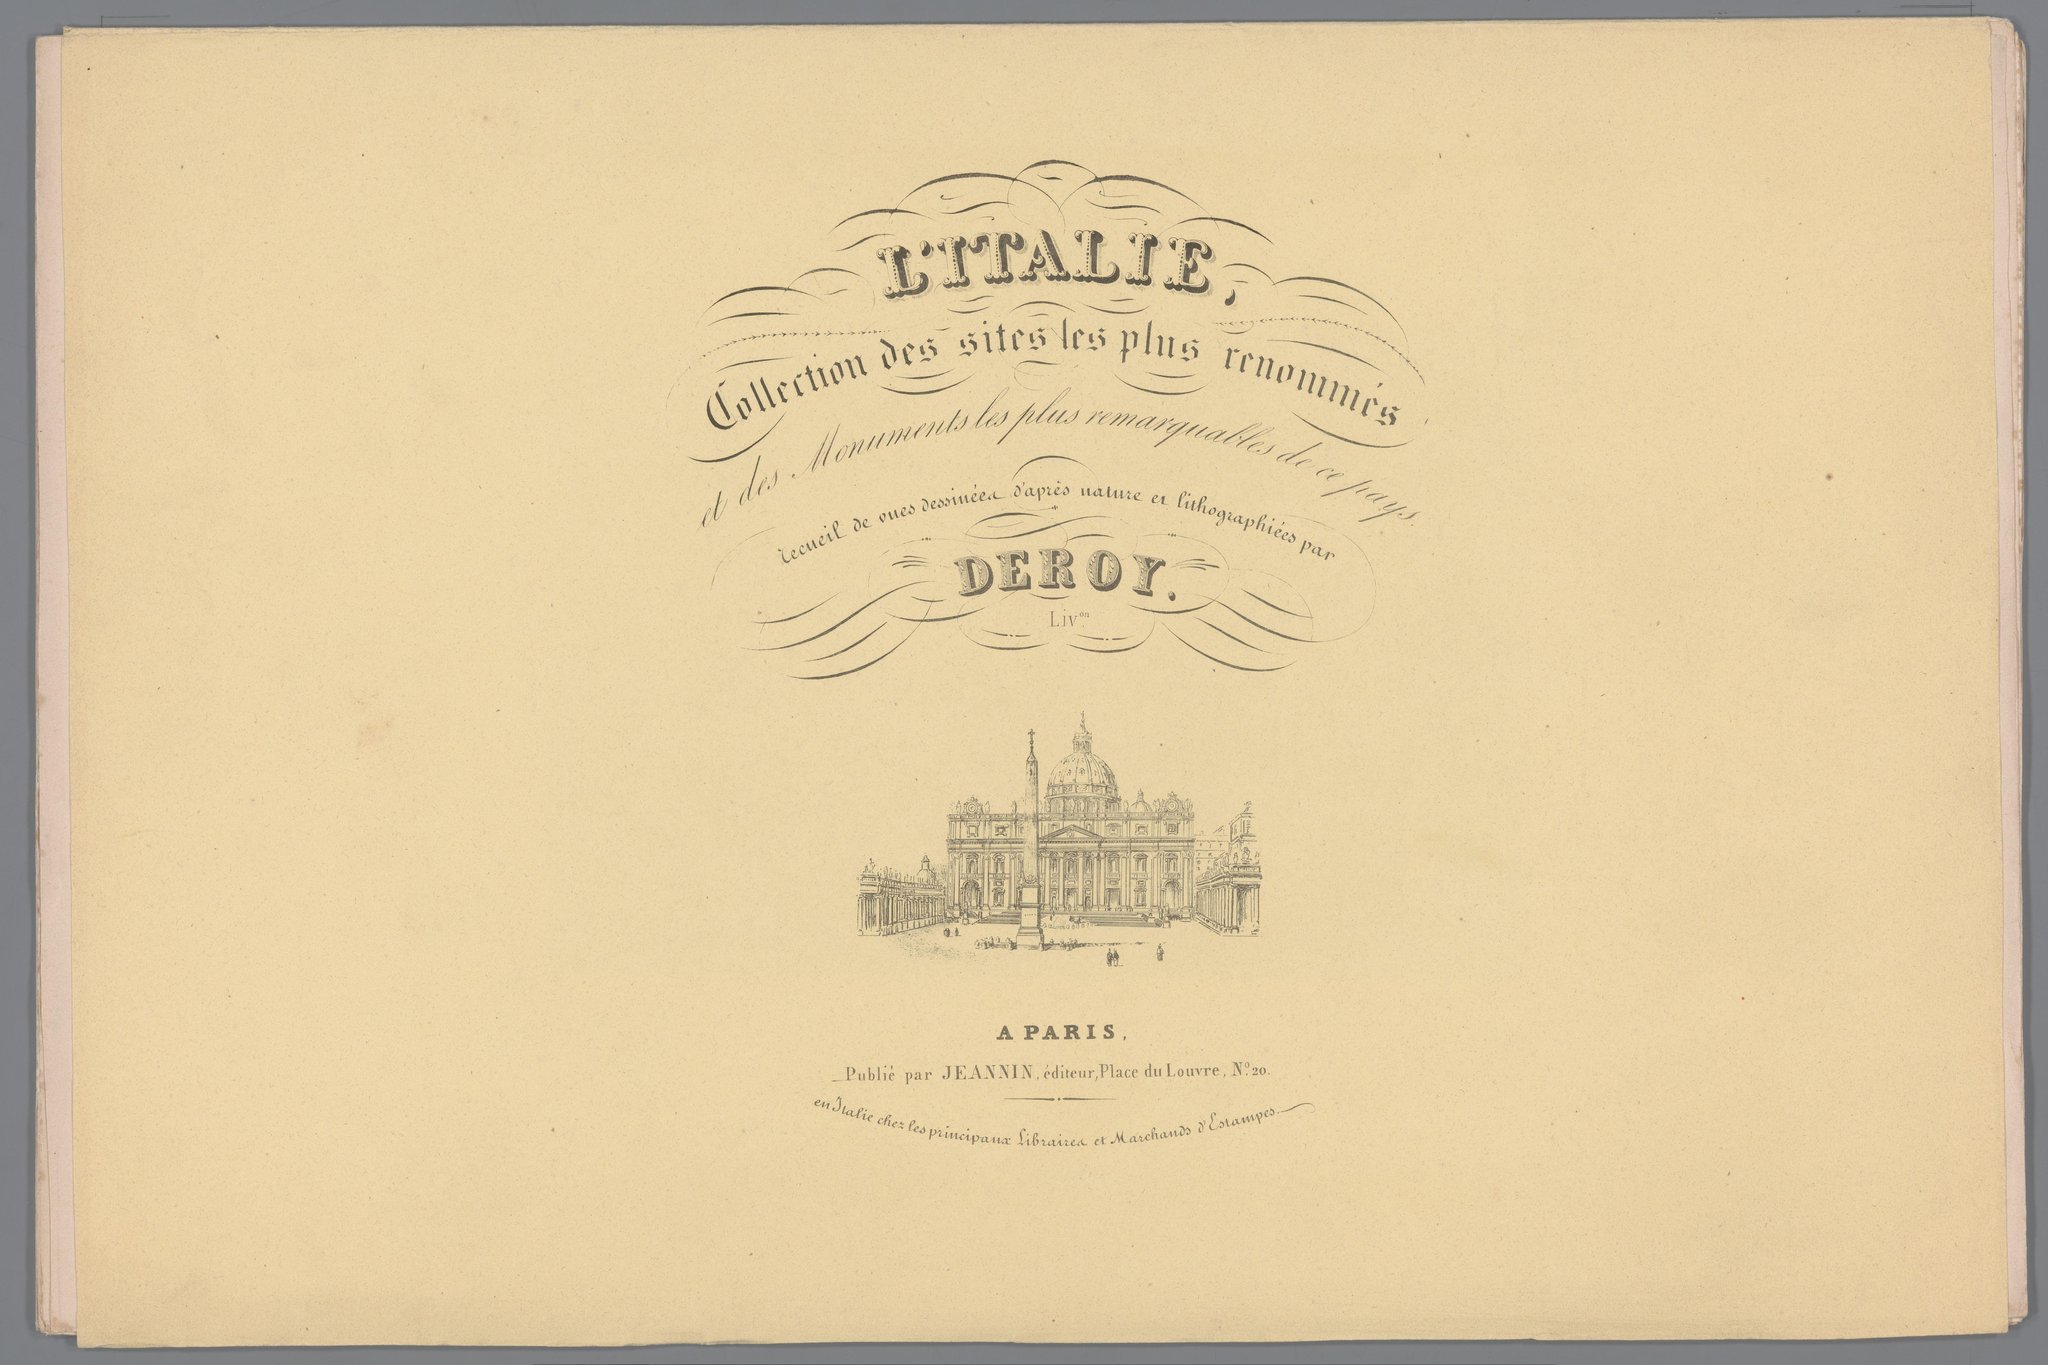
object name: wrapper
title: Gezichten in Italië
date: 1838-1841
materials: paper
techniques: lithograph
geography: paris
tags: church (exterior)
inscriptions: collector's mark: Lugt 2228a